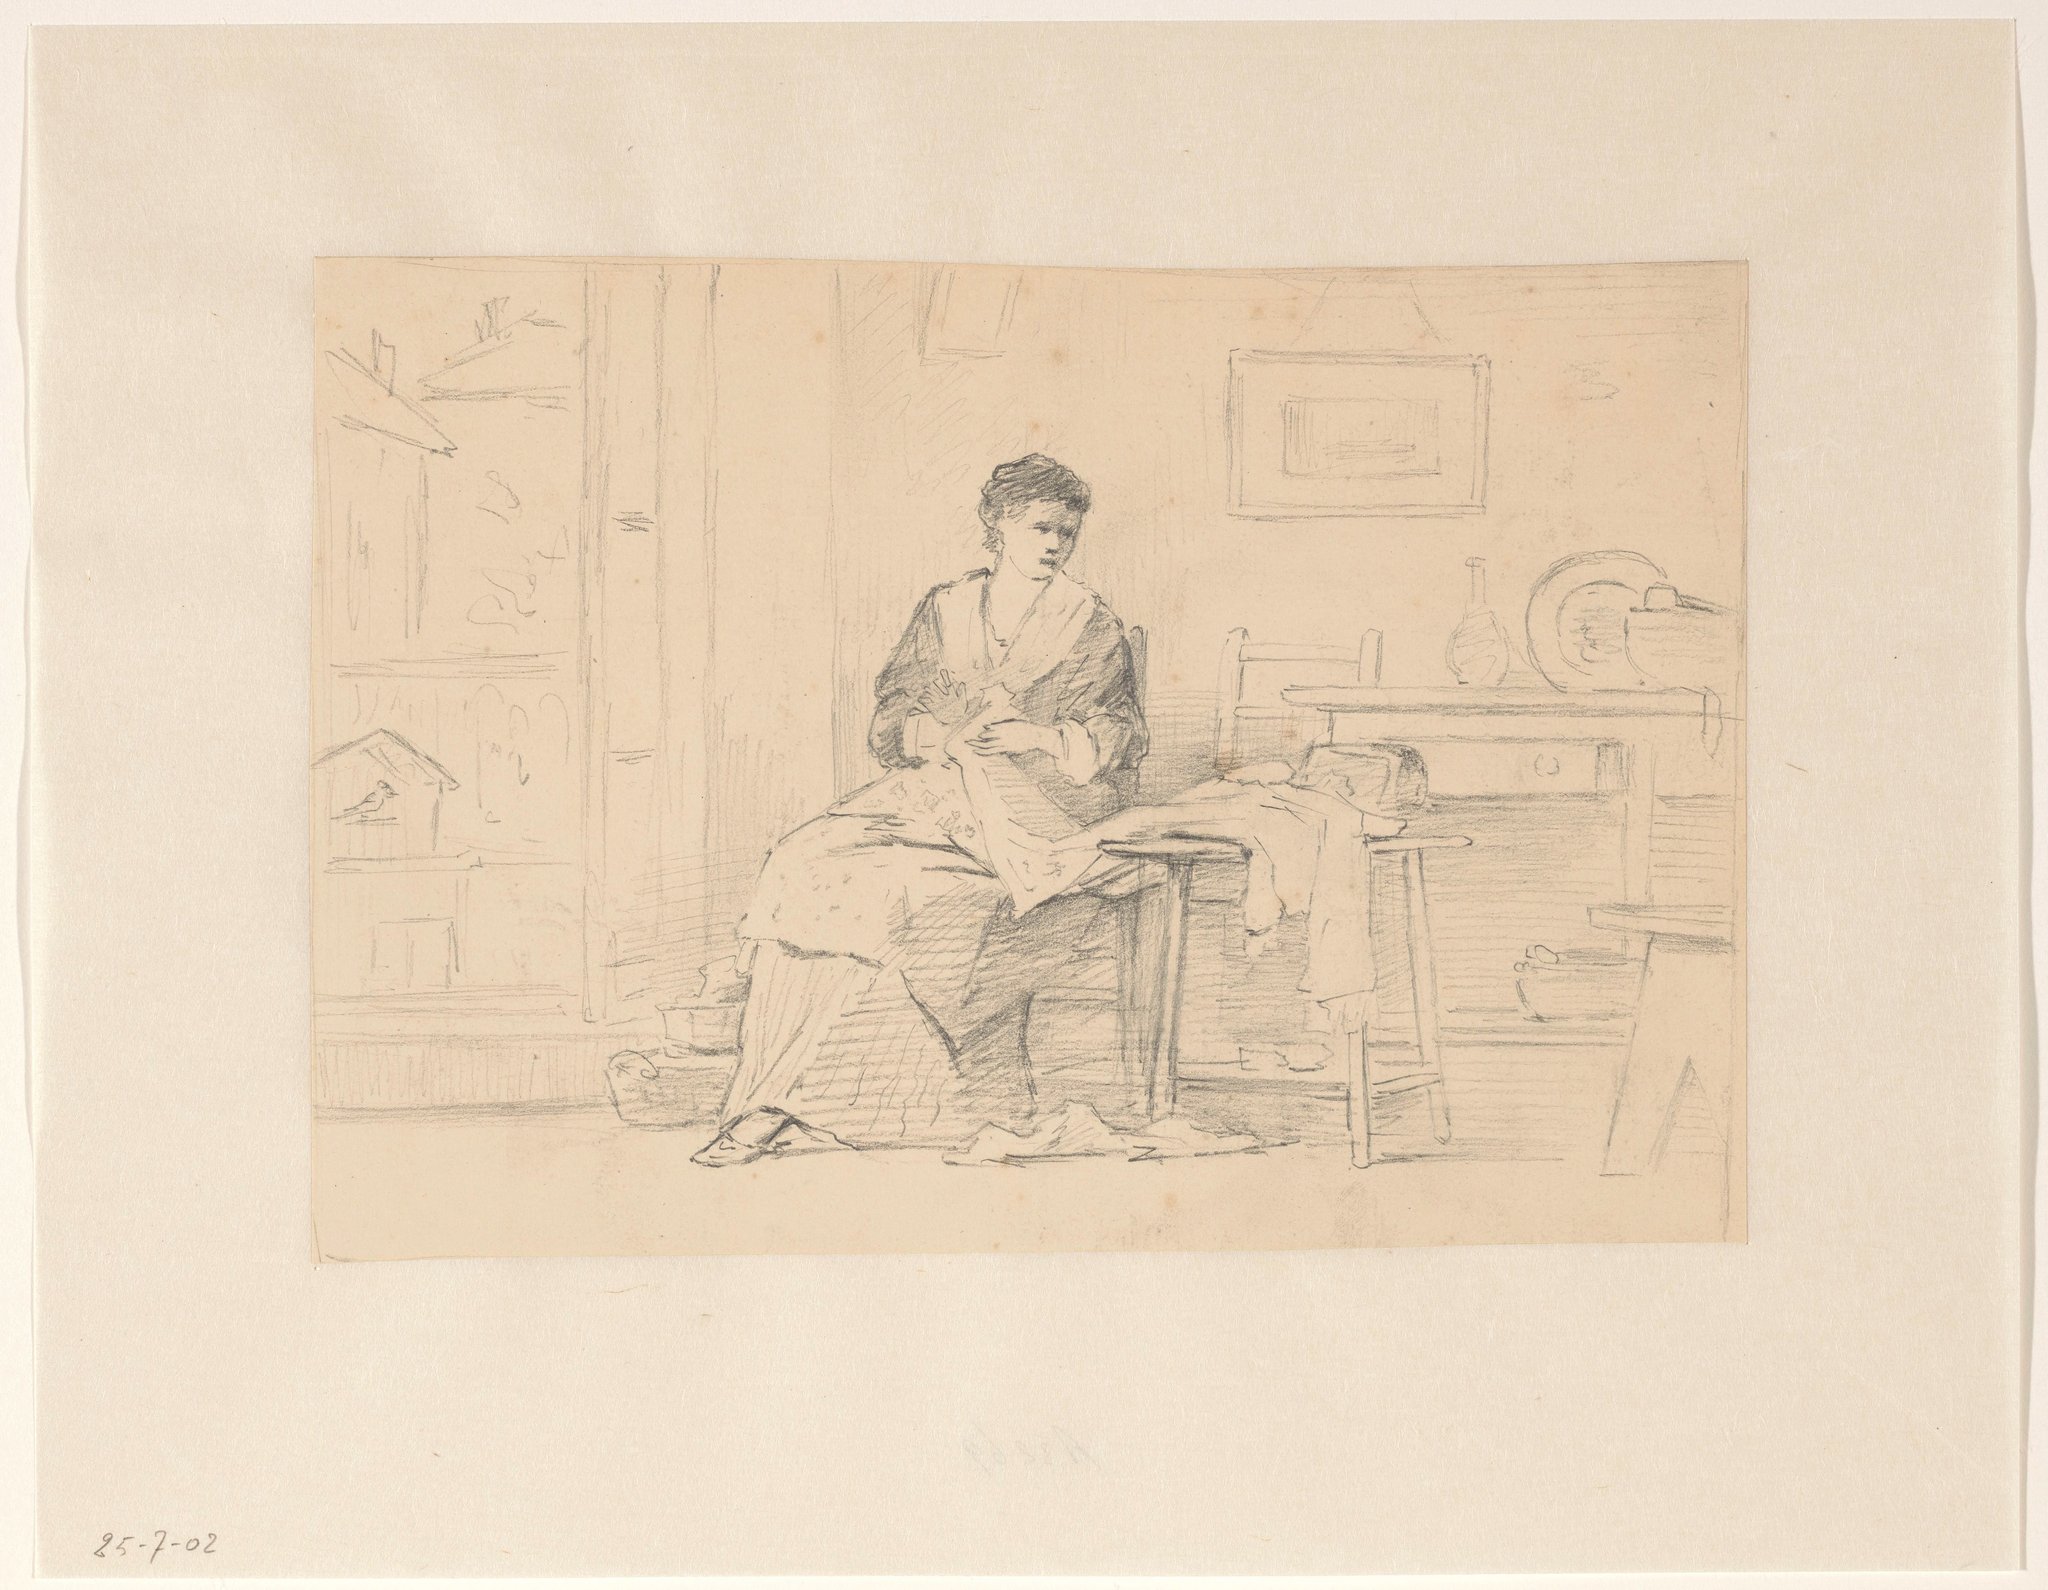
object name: drawing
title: Interieur met jonge vrouw met handwerk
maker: hendrik valkenburg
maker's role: draughtsman, painter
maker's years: 1826-1896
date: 1836-1896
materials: paper, pencil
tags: adult woman, interior of the house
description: Jonge vrouw, van voren, zittend met een handwerk. Verso: tweemaal een staande vrouw bij de huiselijke arbeid.